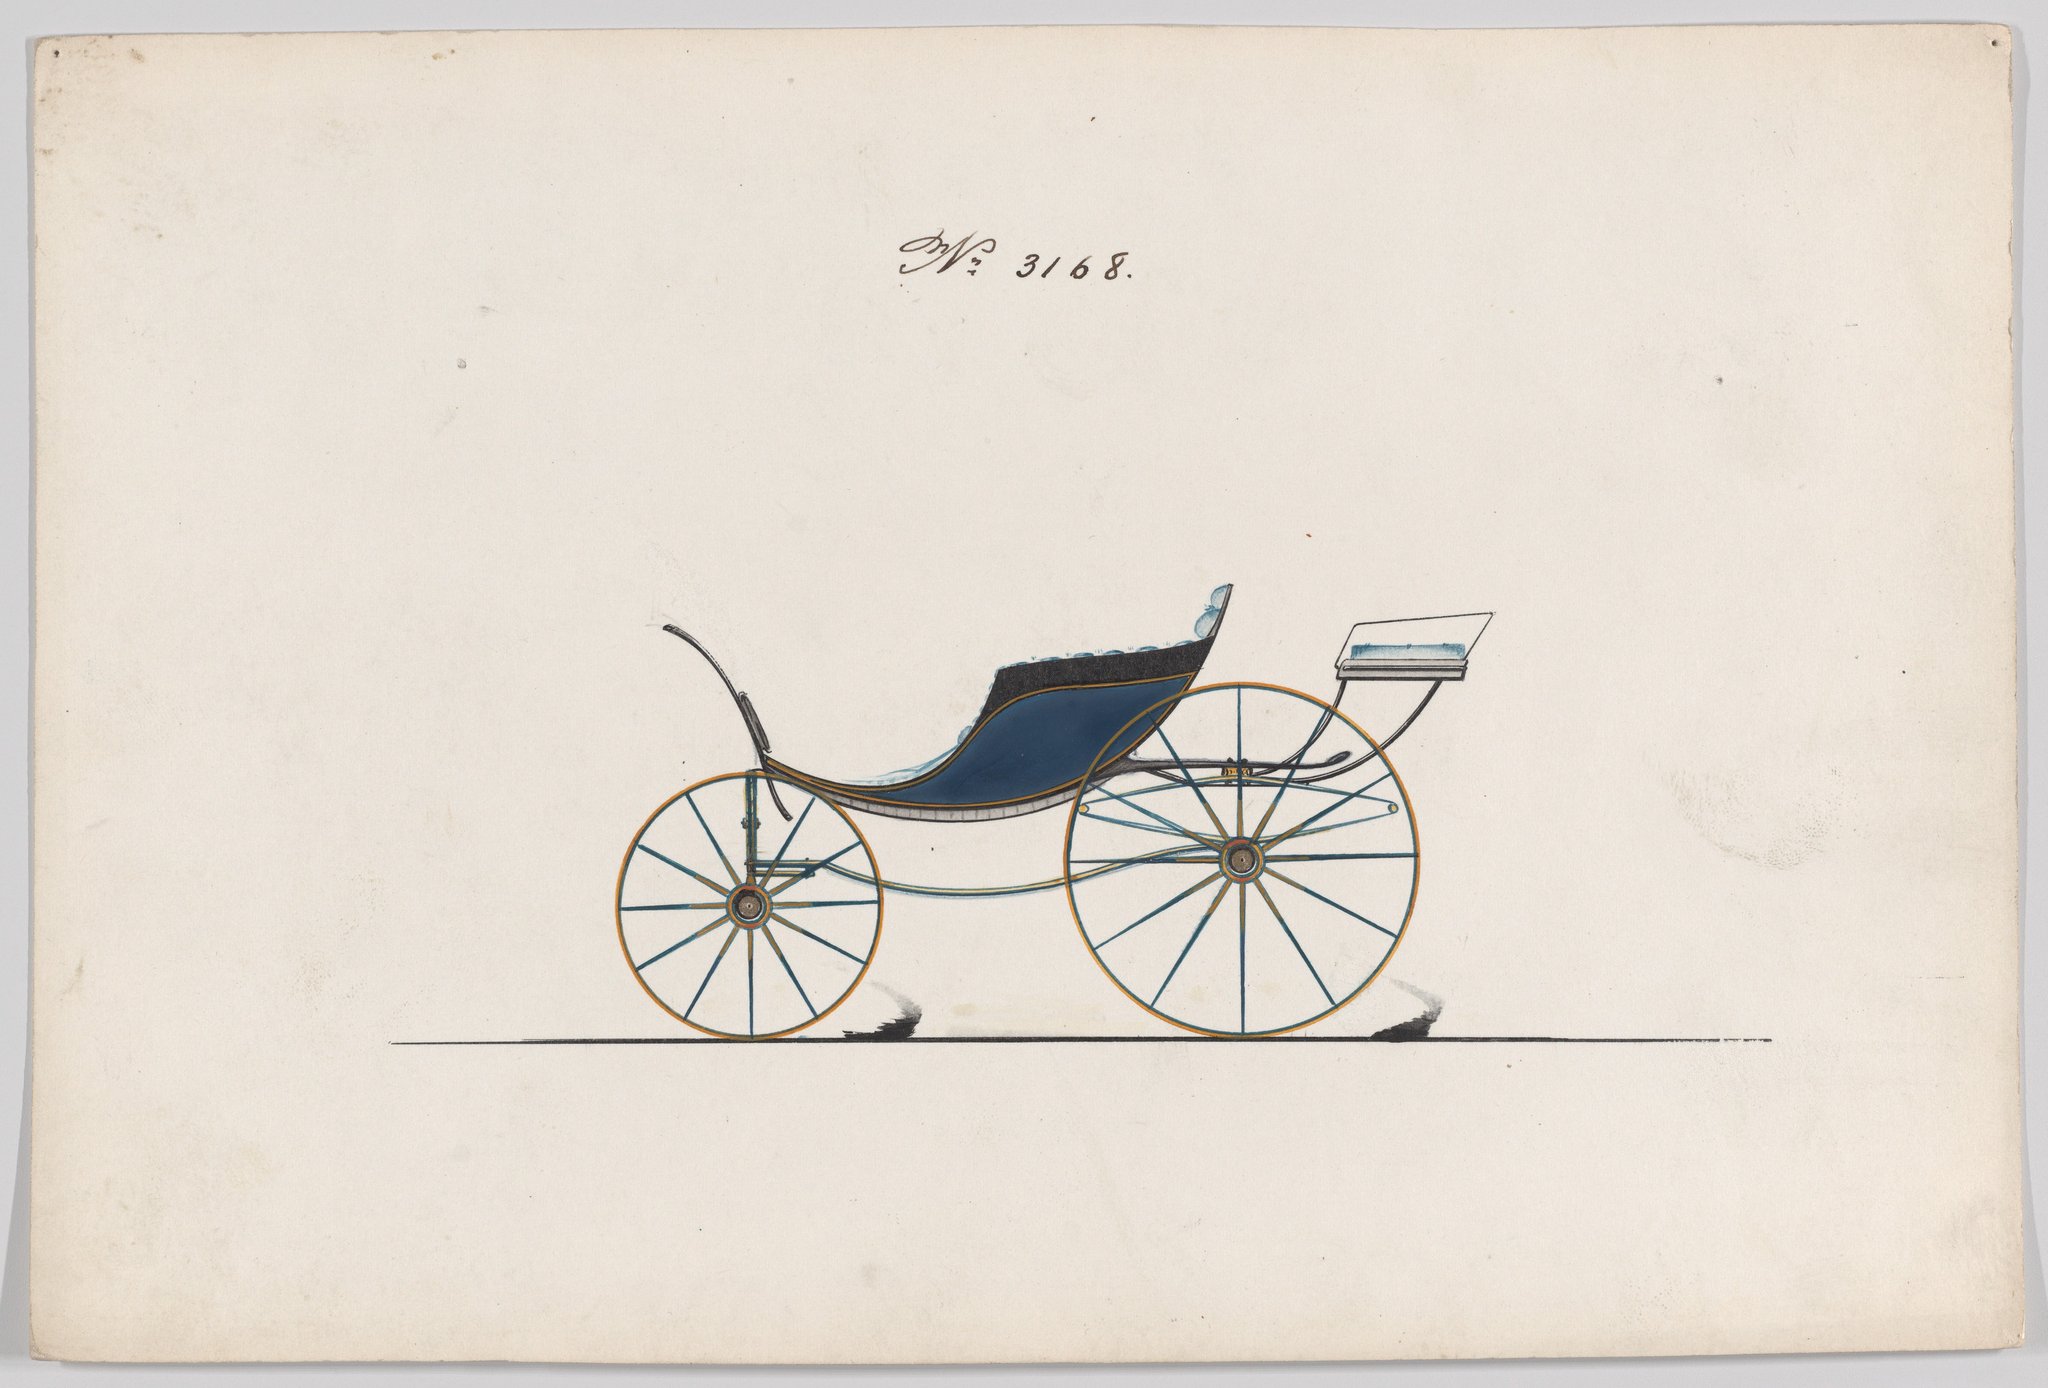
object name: drawing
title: Design for Pony Phaeton, no. 3168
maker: brewster & co.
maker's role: manufacturer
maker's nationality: american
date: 1875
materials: gouache, ink, watercolor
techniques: pen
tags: carriages